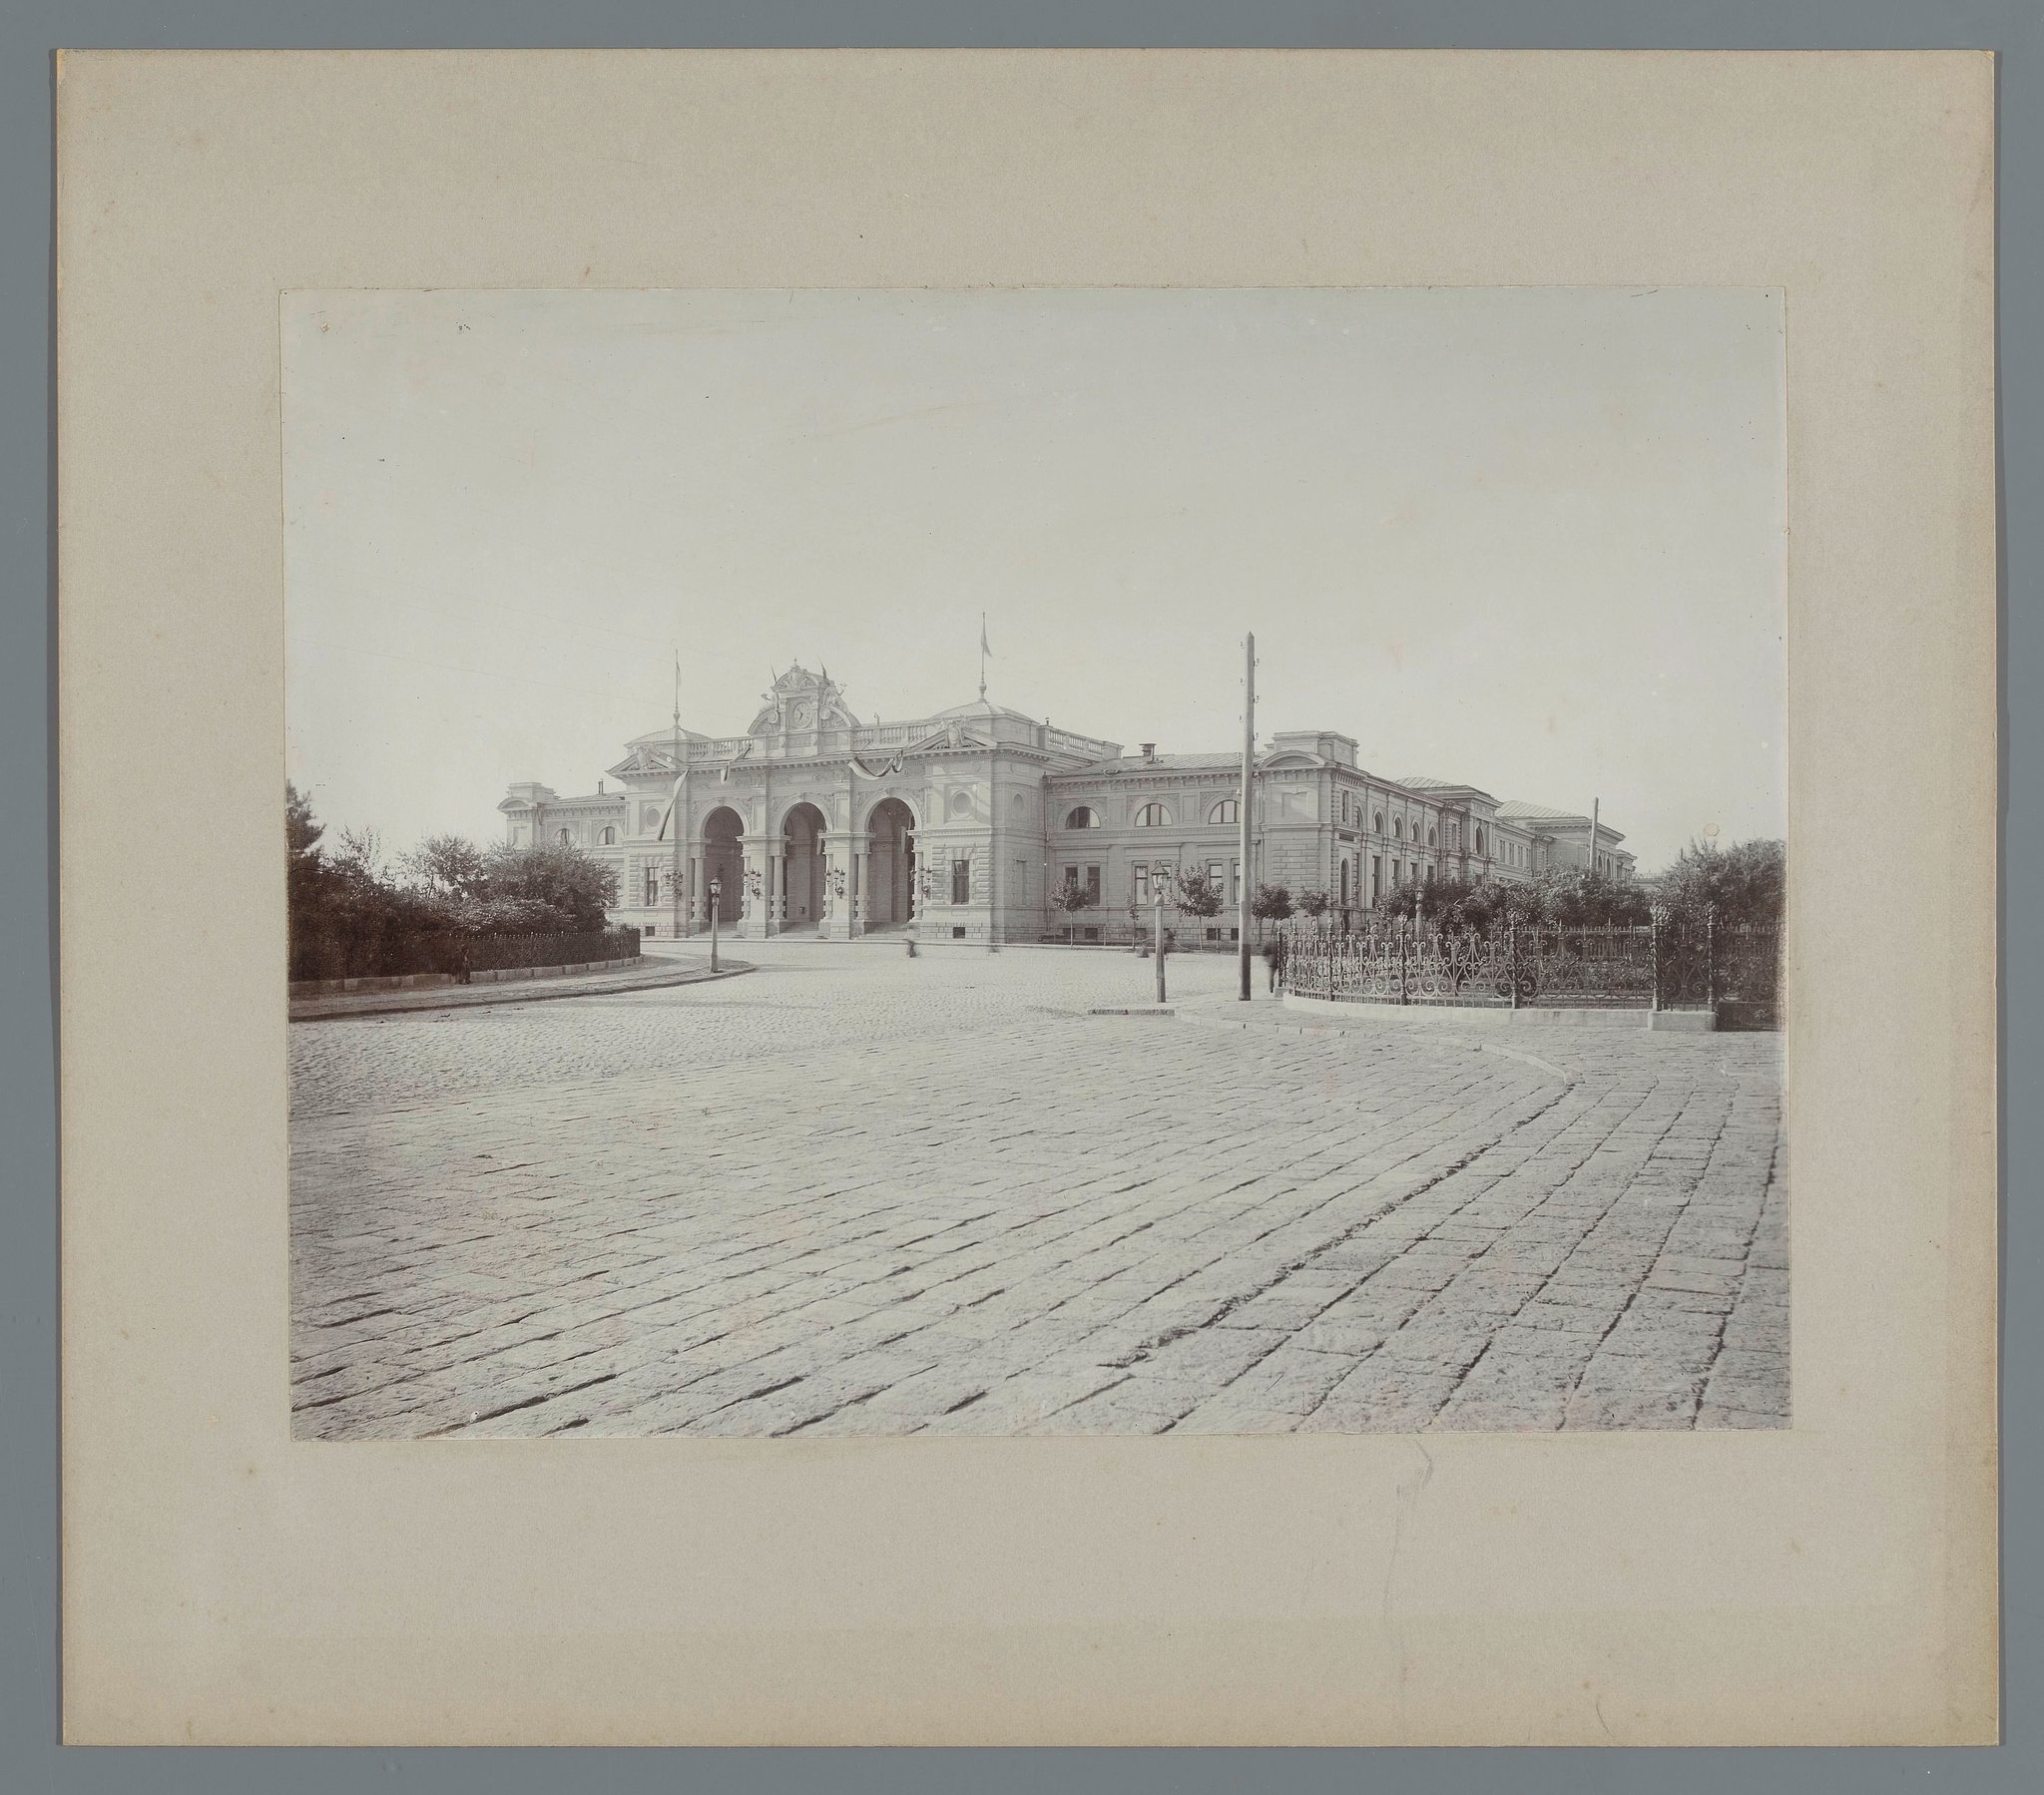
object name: photograph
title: Gebouw in Rusland, mogelijk in Sint-Petersburg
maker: Anonymous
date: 1880-1910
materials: paper, cardboard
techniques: collodion silver print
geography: sint-petersburg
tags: edifice, e.g.: public building, department store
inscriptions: inscription: ‘Leningrad?’